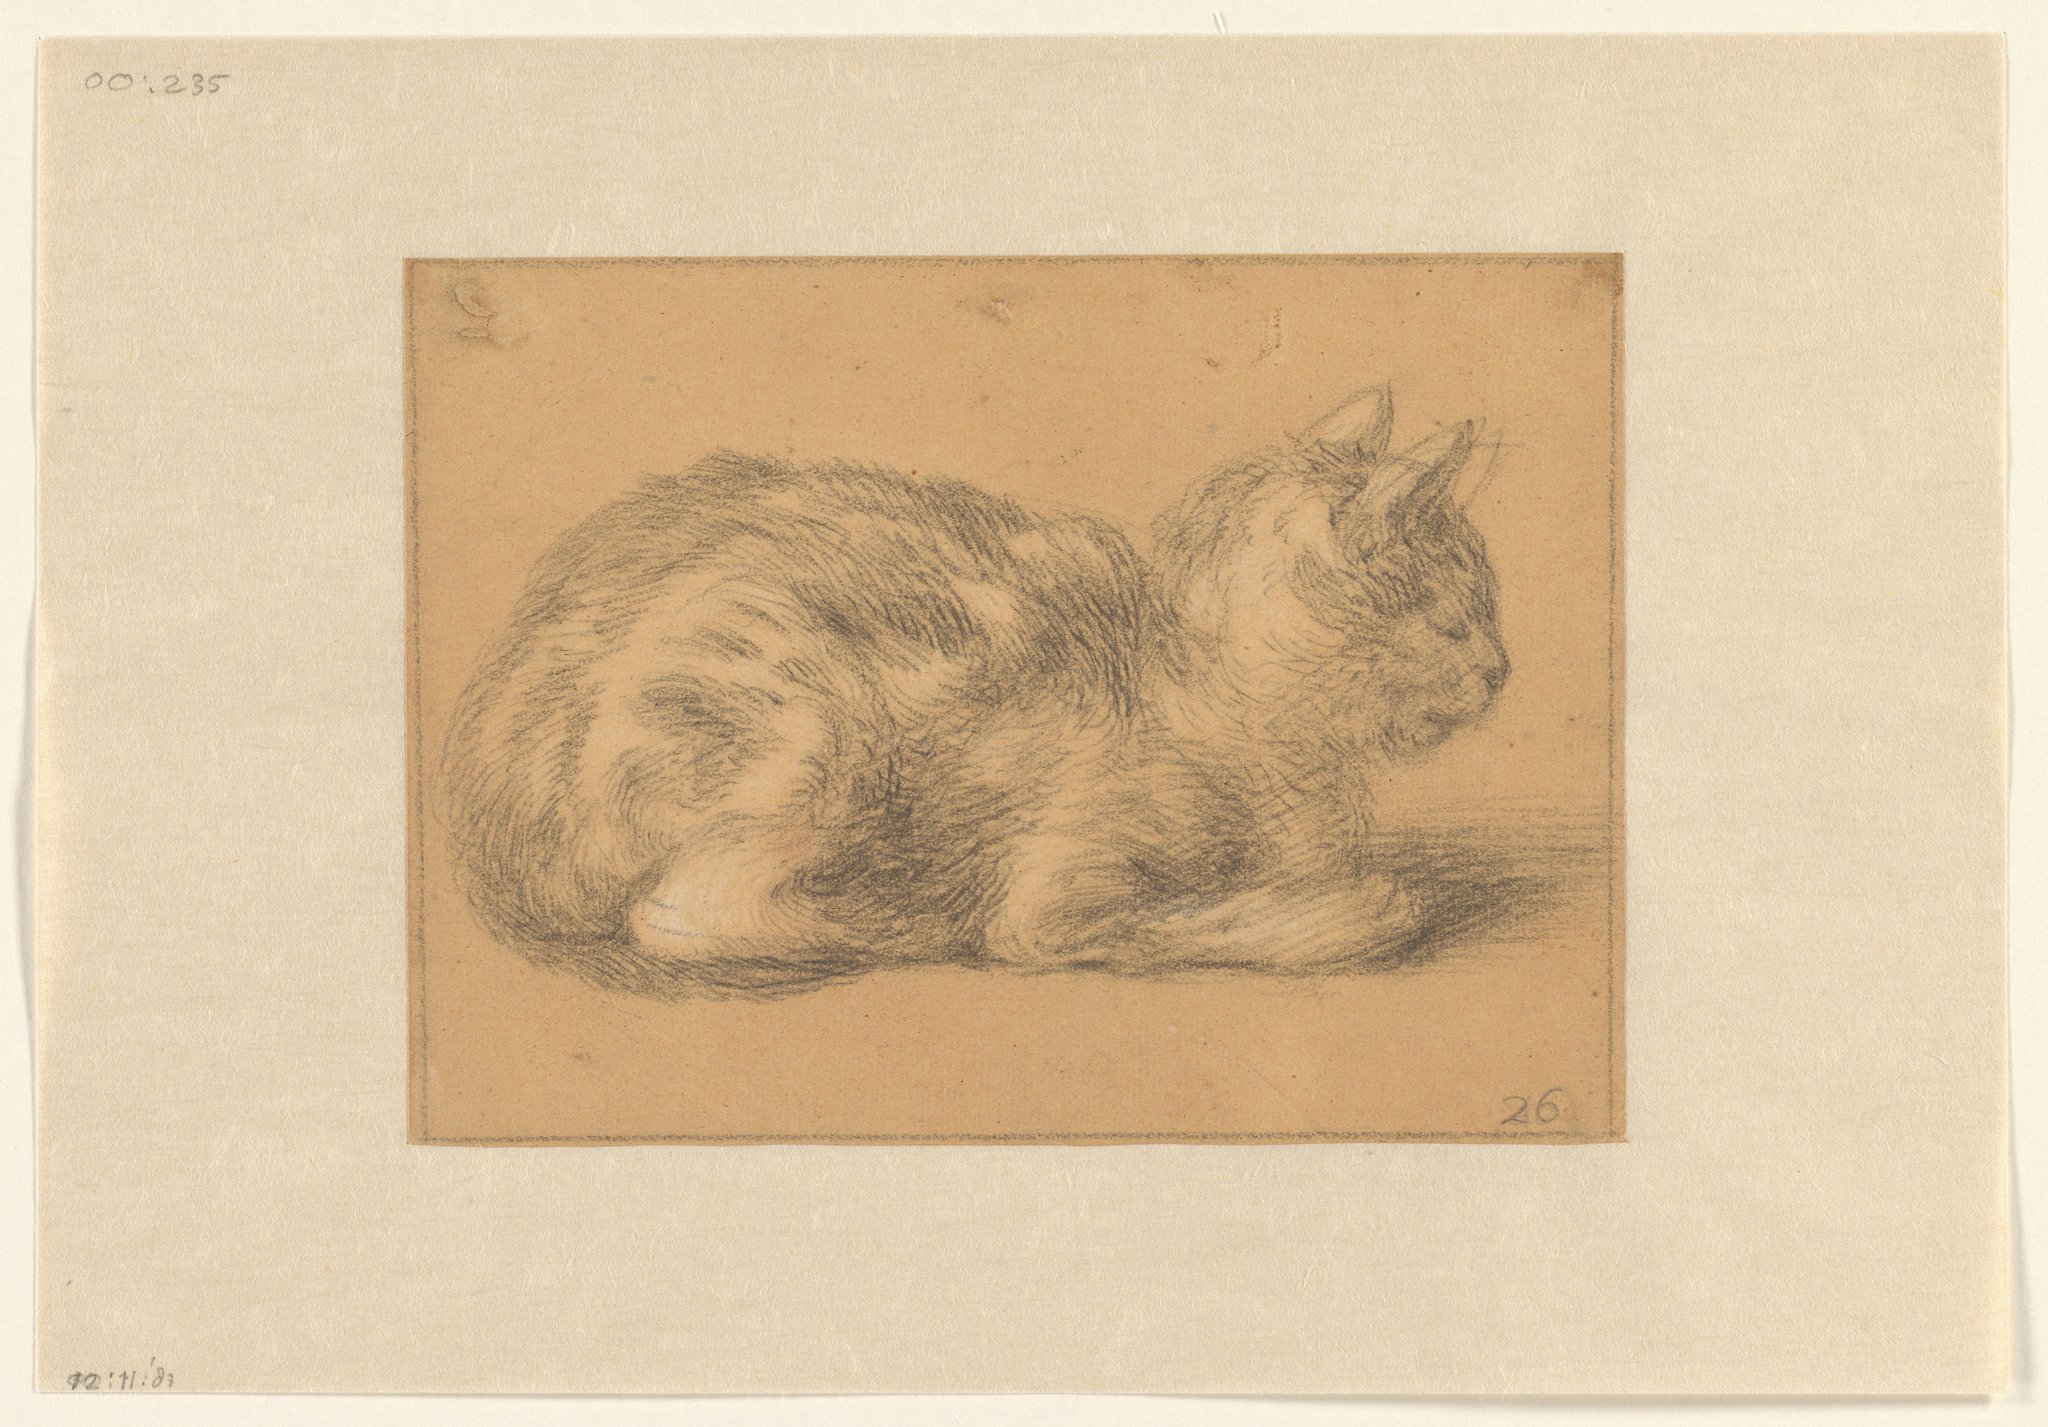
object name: drawing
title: Zittende kat, naar rechts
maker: cornelis saftleven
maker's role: draughtsman, painter, print maker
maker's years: 1607-1681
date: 1617-1681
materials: chalk, paper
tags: cat